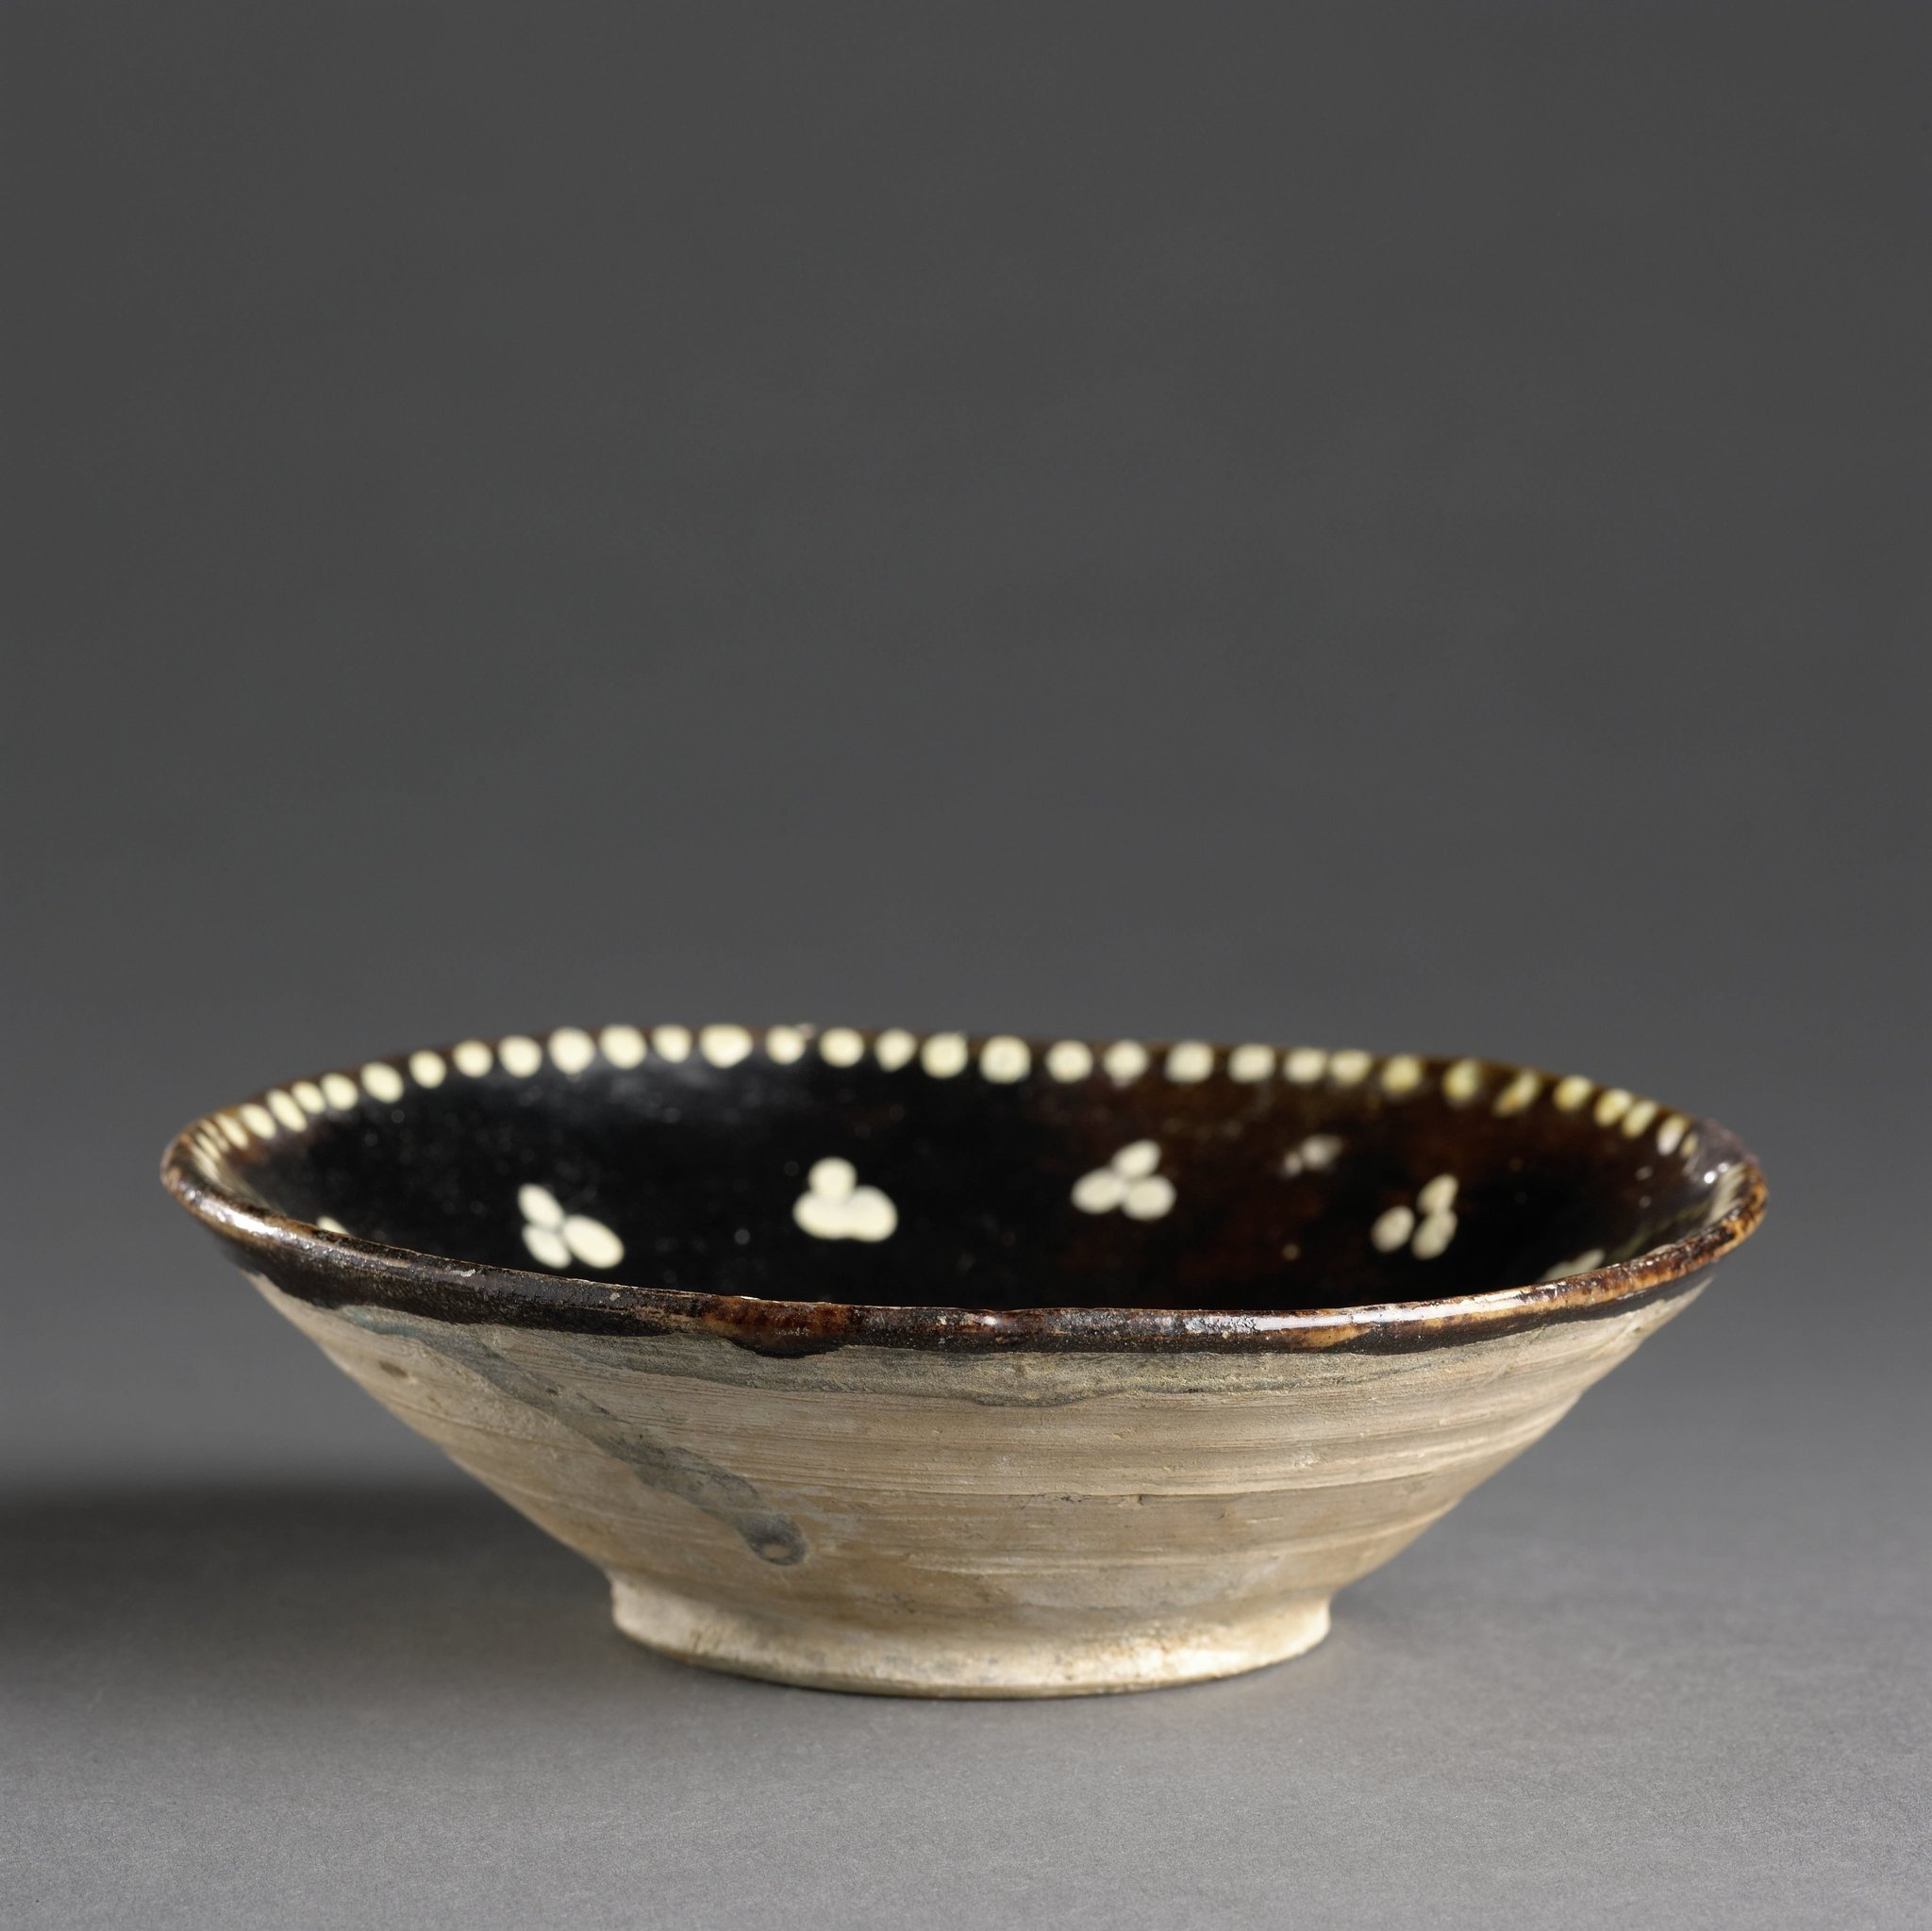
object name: bowl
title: bowl with groups of three white dots on a brown ground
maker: Anonymous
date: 900-1099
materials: earthenware, glaze, paint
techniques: firing, turning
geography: nishapur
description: Bowl. Northeast, Iran 9th - 10th century. Earthenware. Given by Prof. Dr J.A. Oosterbaan and Mrs Oosterbaan-Lugt.